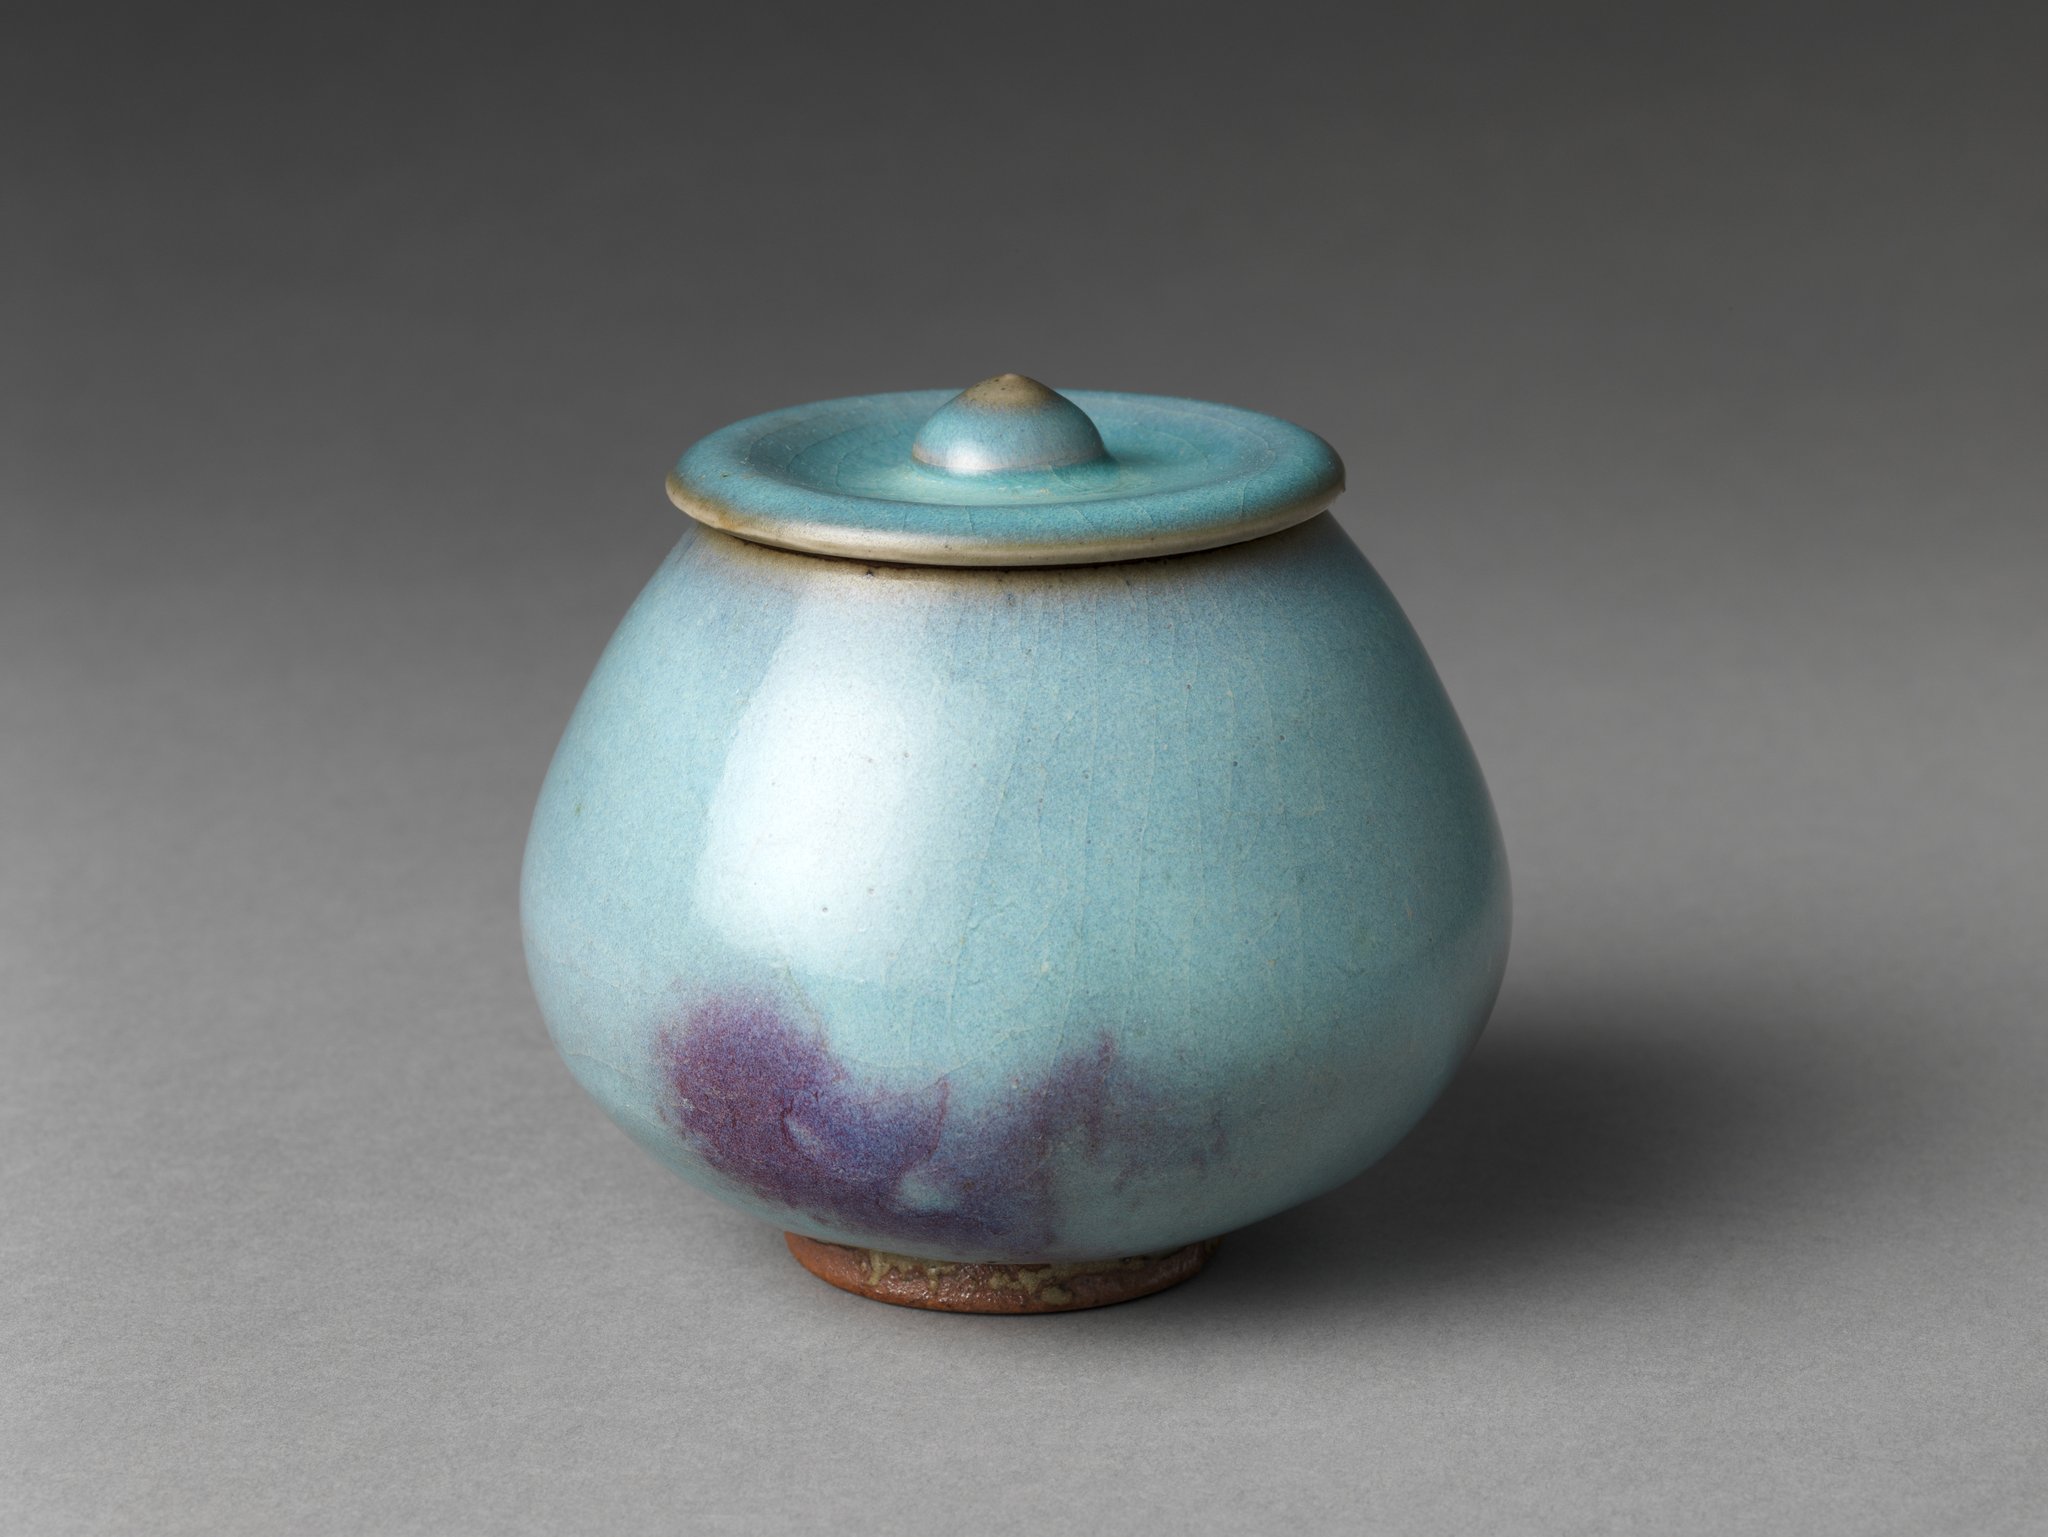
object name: jar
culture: chinese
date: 1001-1200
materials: glaze, stoneware